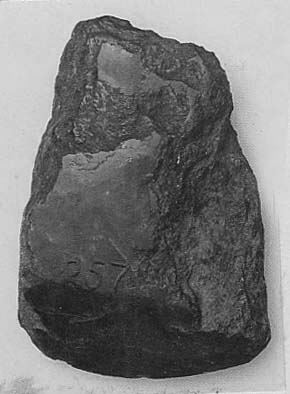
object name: hatchet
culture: north american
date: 1902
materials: jade